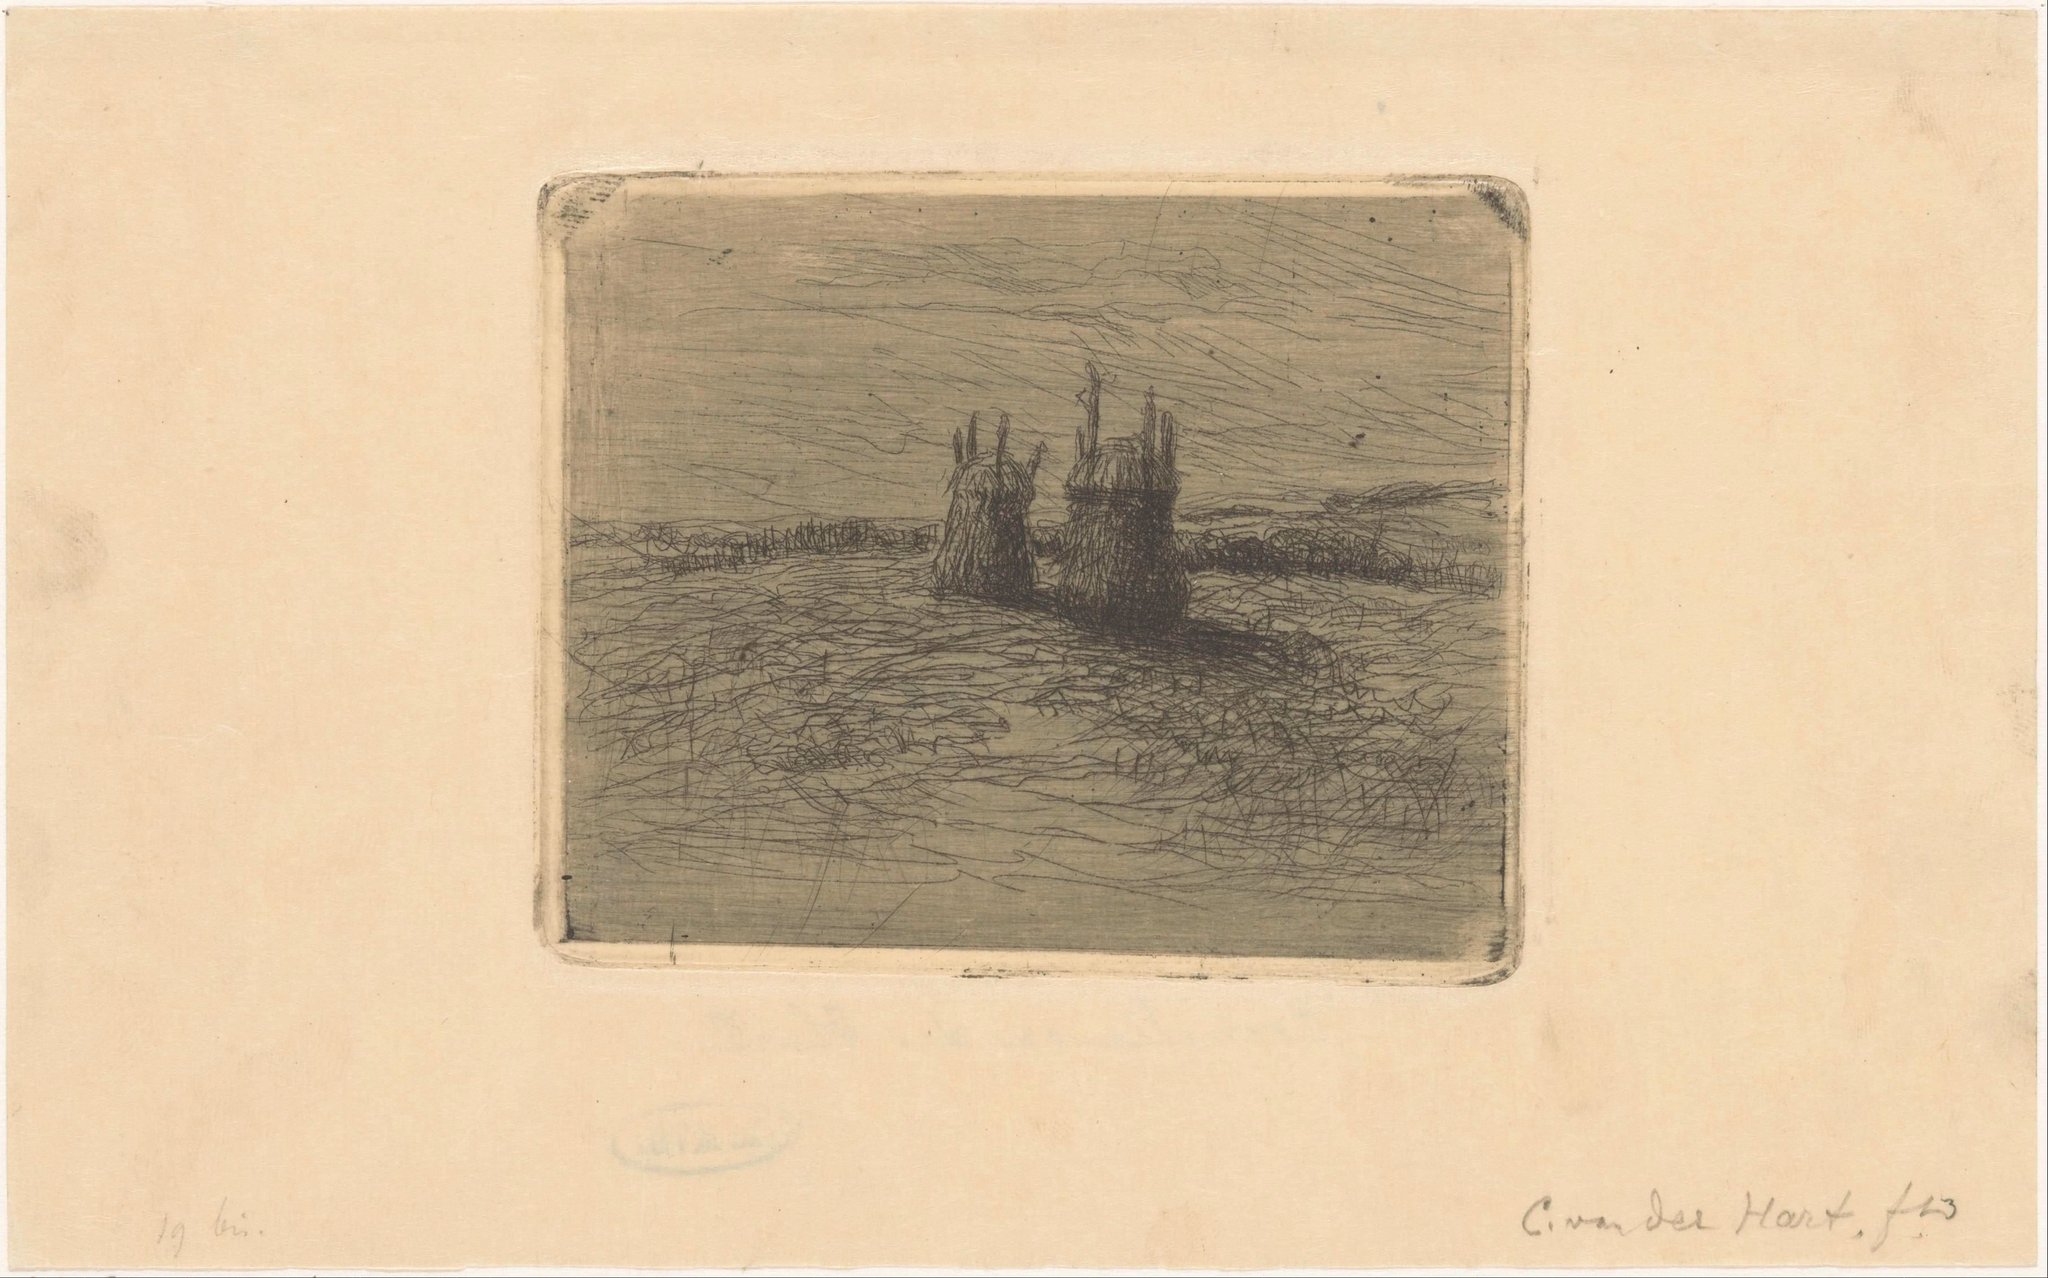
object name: print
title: Landschap met hooibergen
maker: cornelia van der hart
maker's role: print maker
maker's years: 1851-1940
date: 1861-1937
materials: paper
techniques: etching, intaglio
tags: hay-stack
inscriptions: collector's mark: Lugt 2228, collector's mark: Lugt 2760